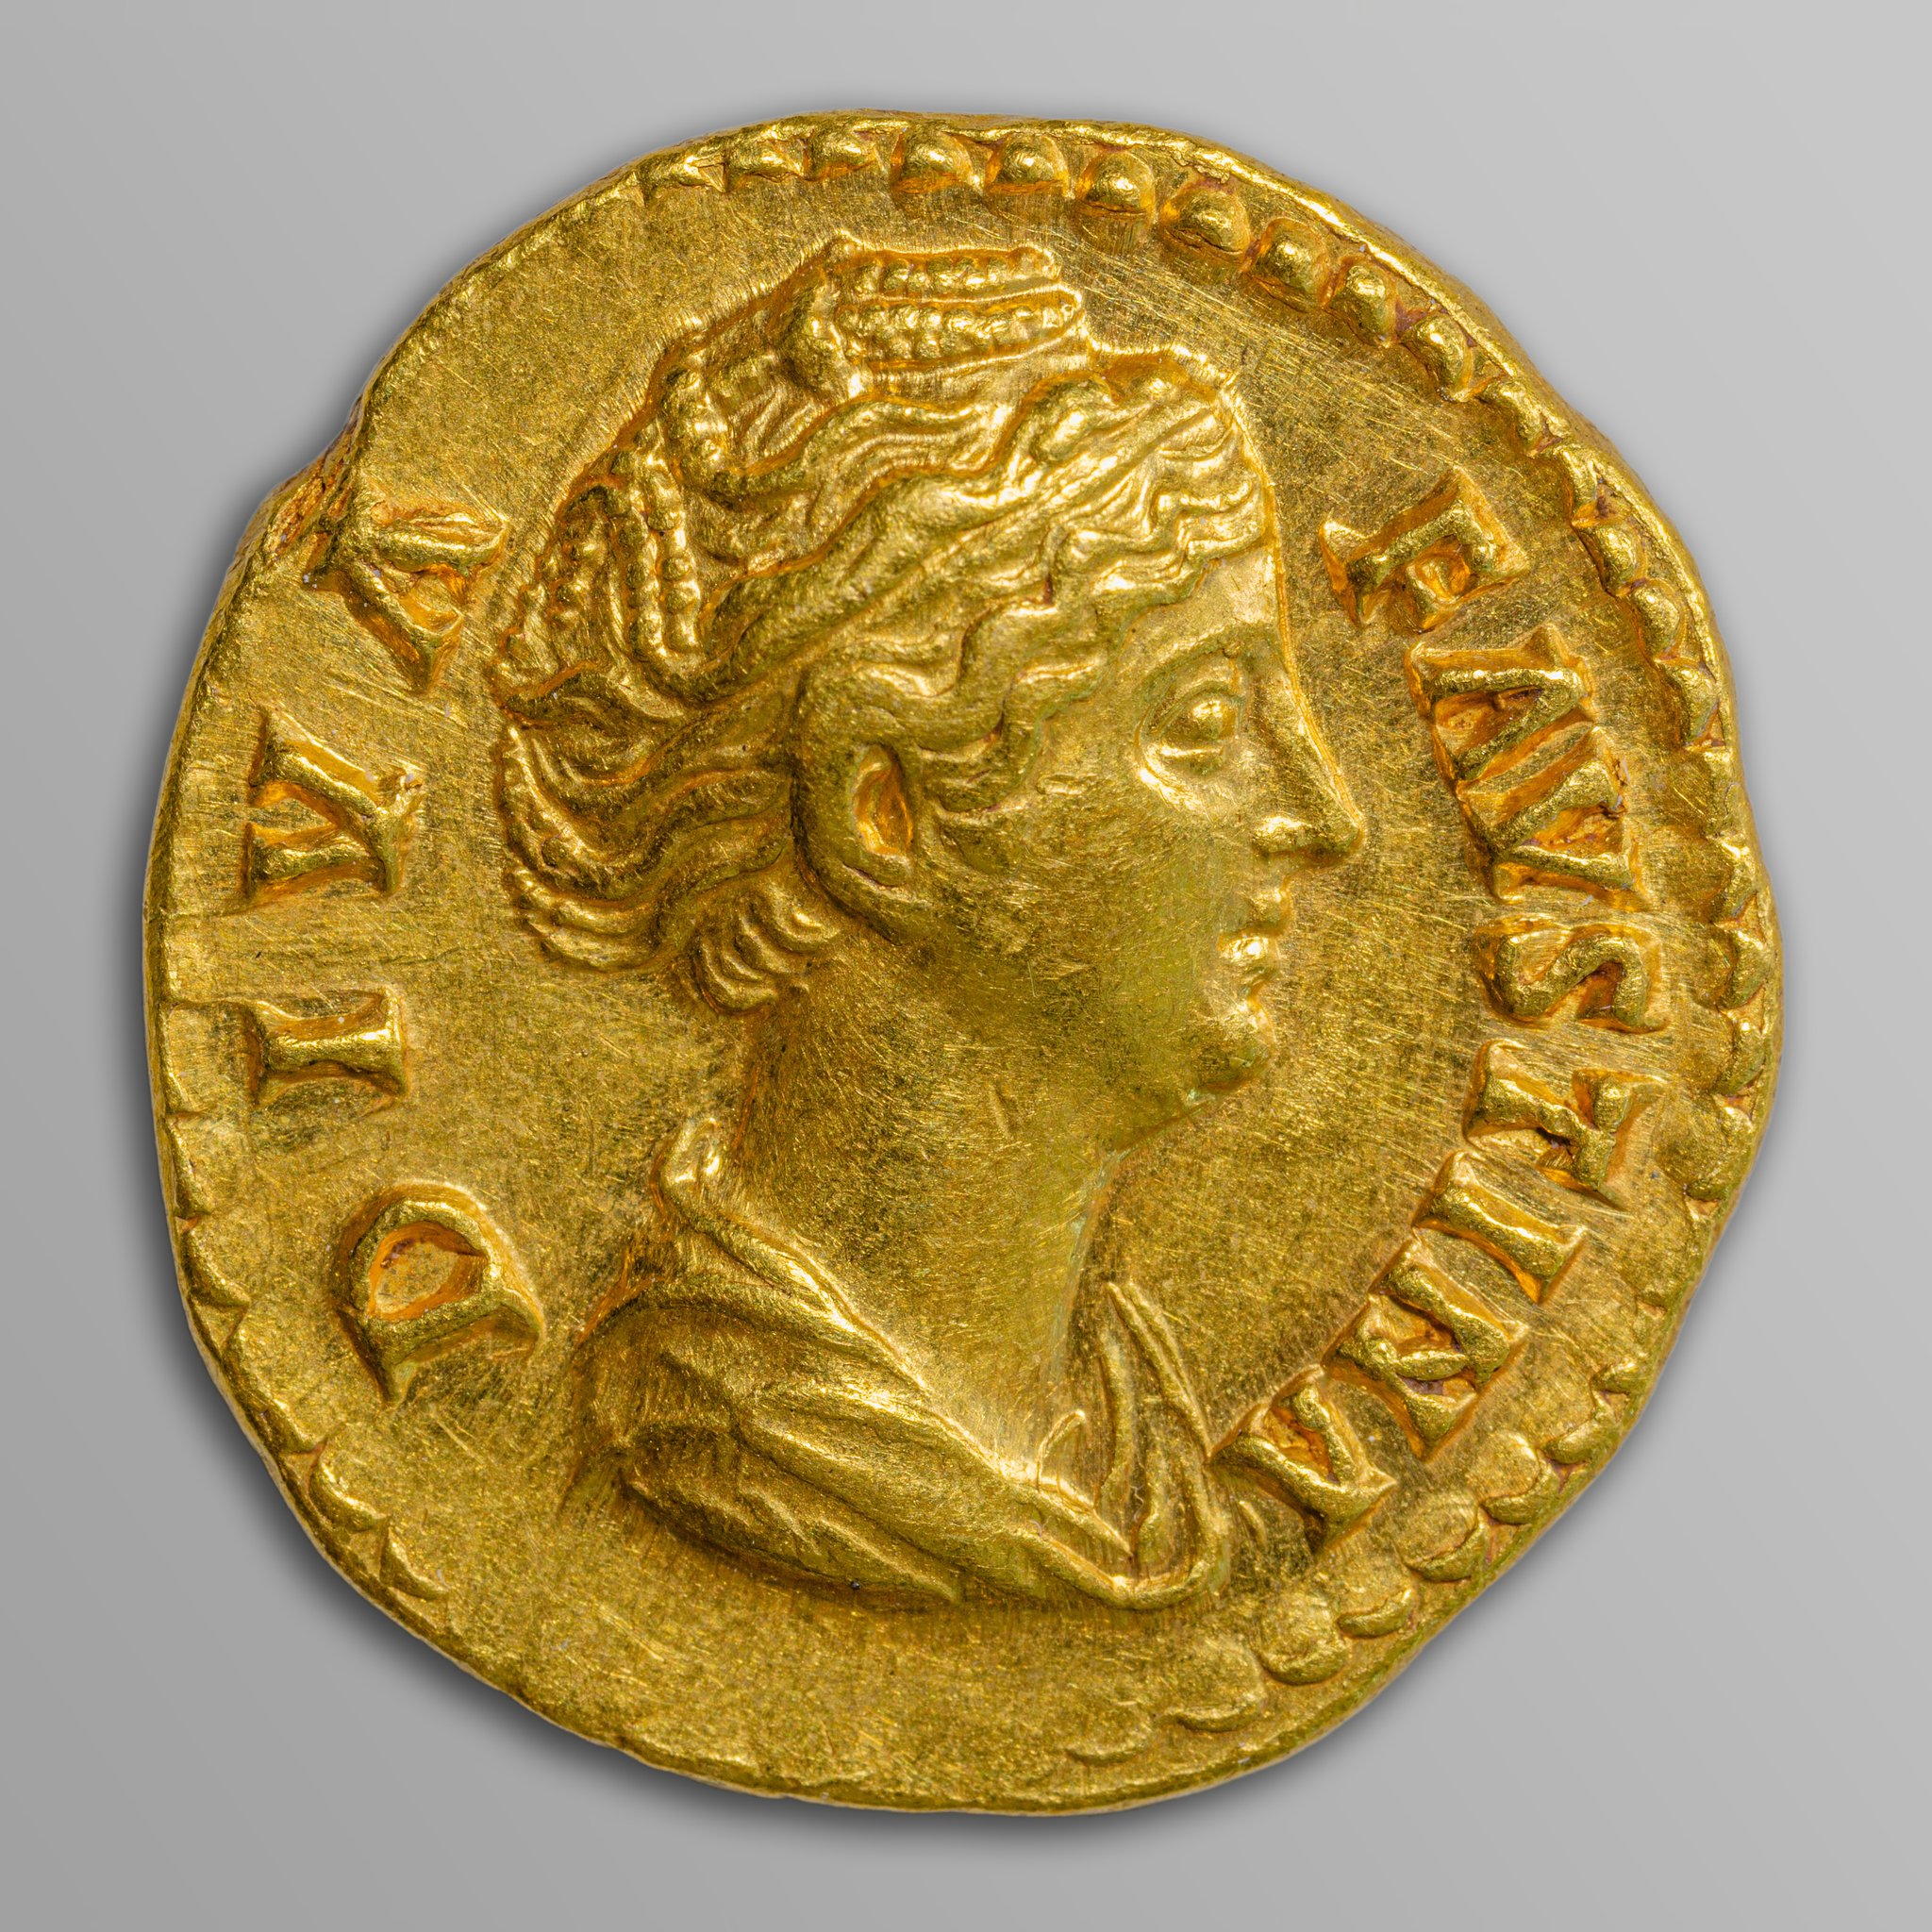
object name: aureus of antoninus pius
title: Gold aureus of Antoninus Pius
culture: roman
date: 141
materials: gold